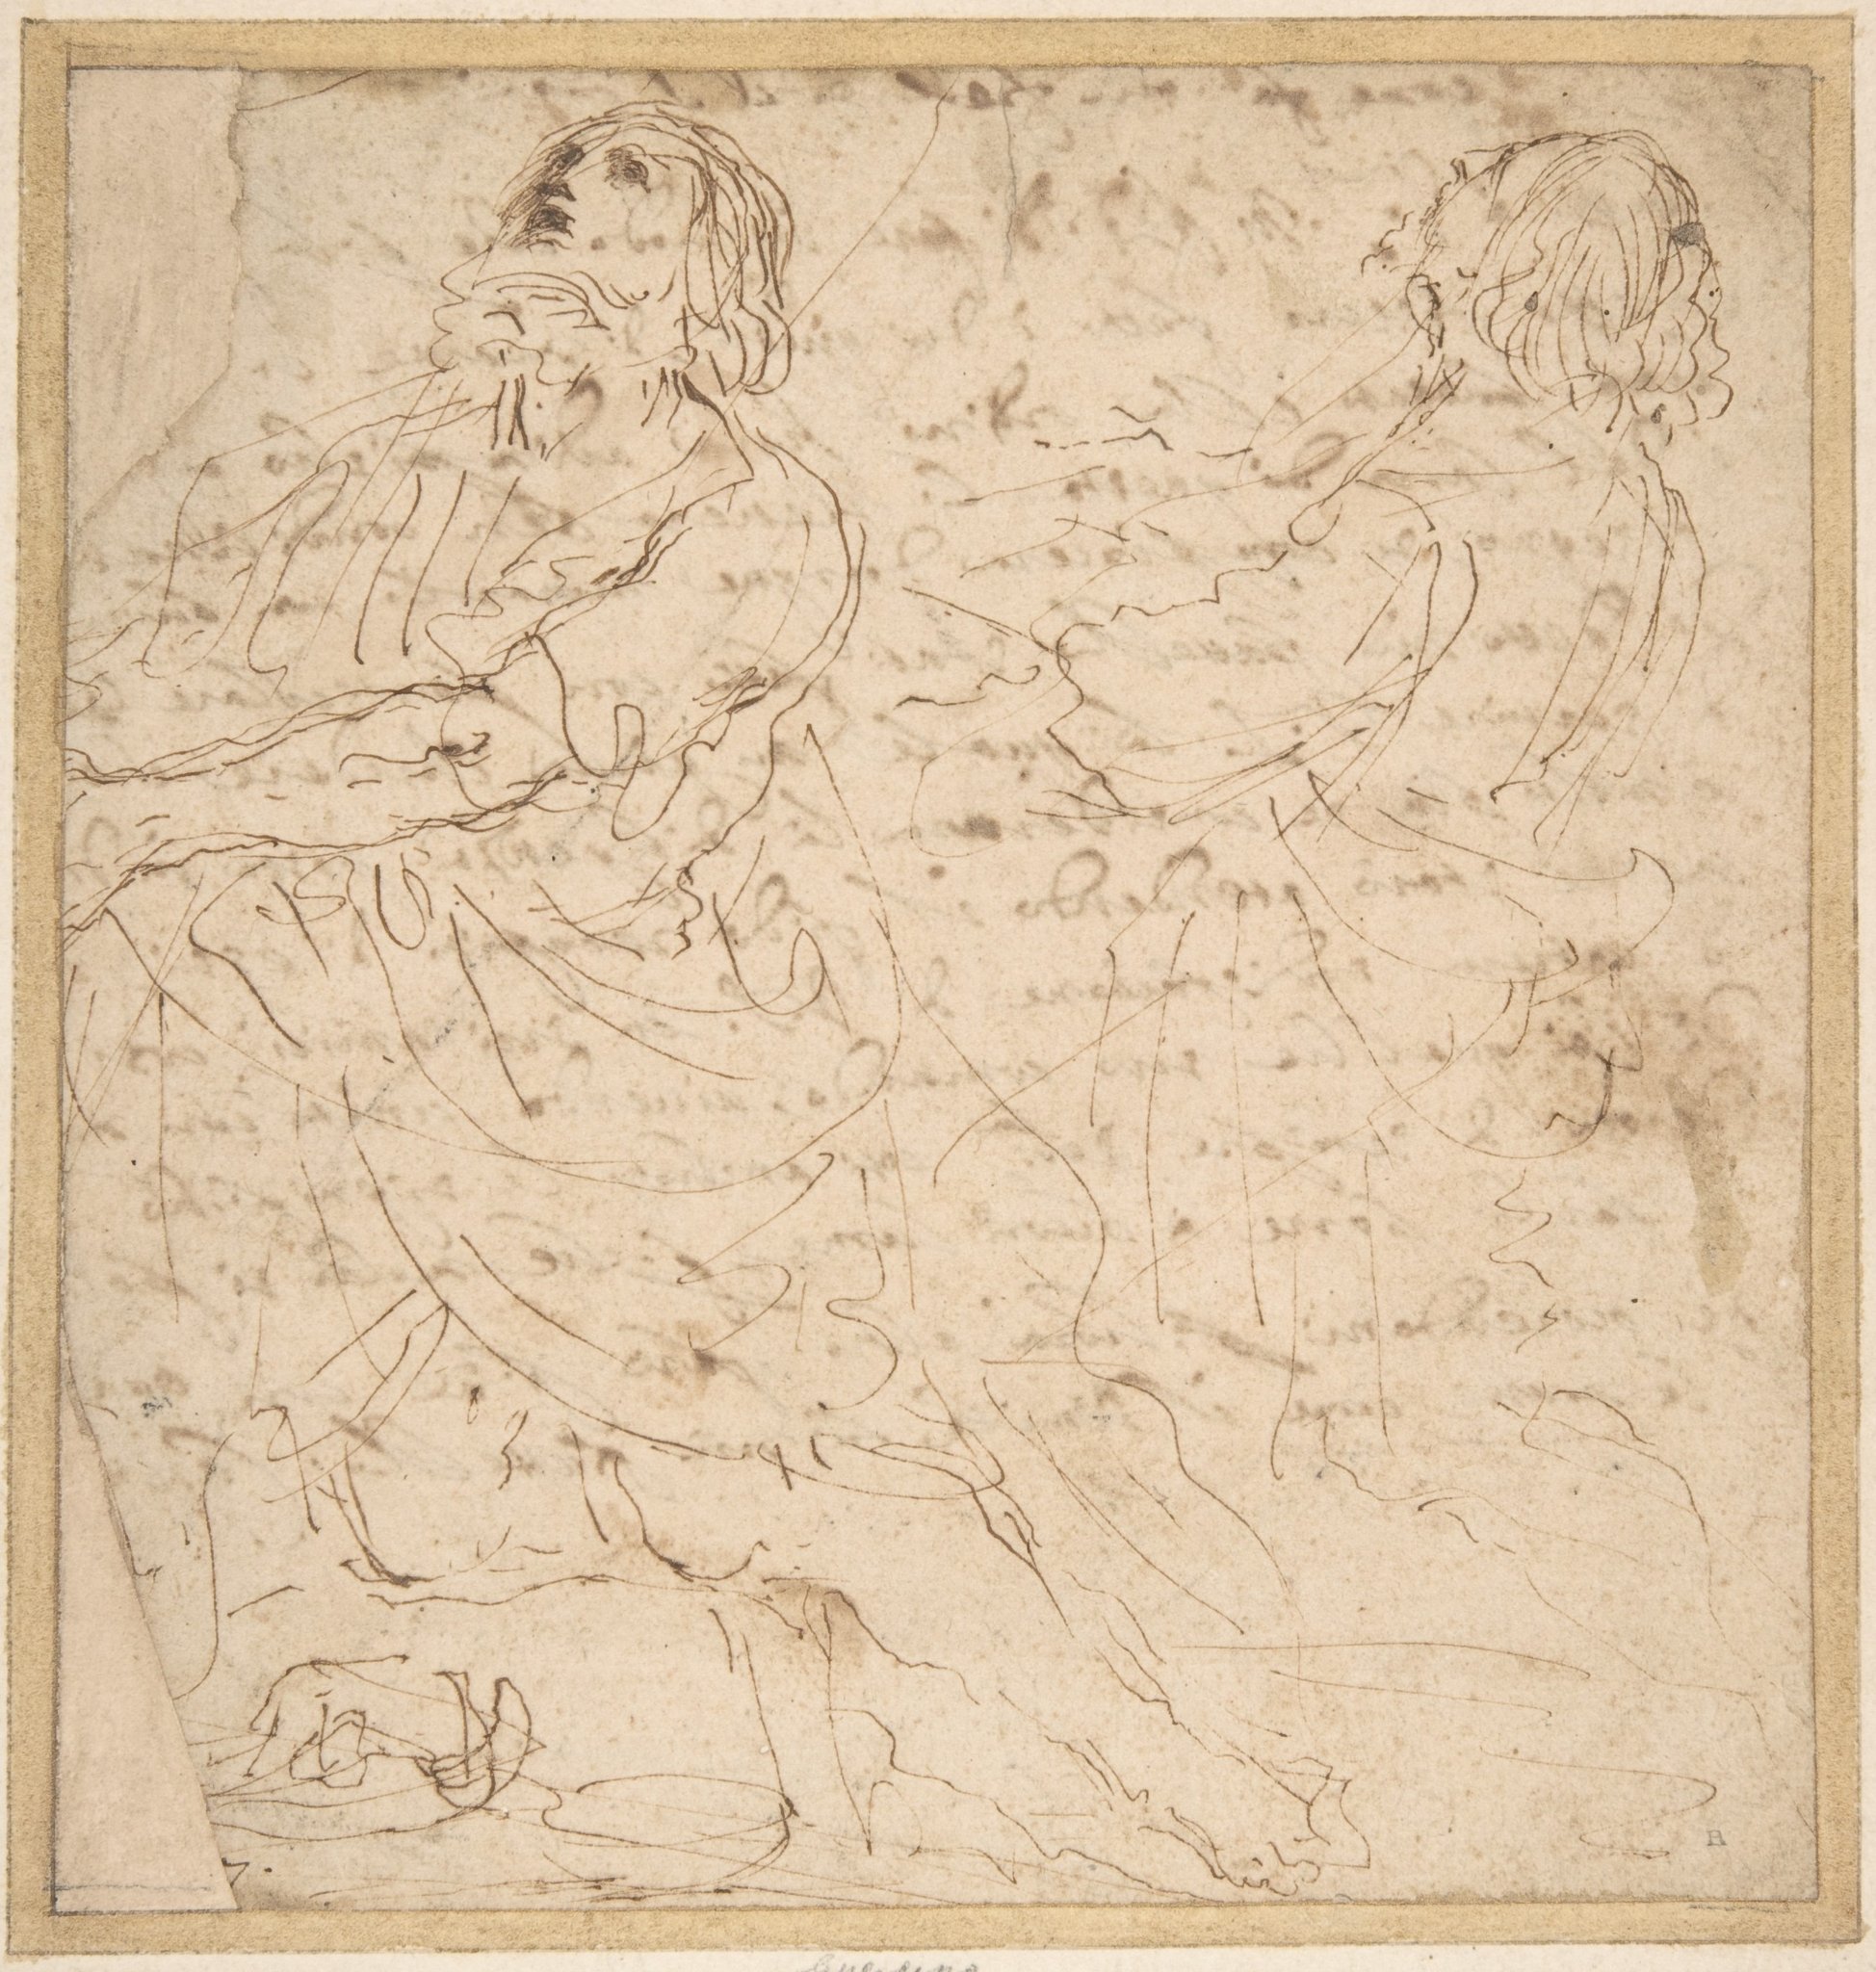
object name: drawing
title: Two Studies of a Kneeling Male Figure (recto); Handwritten letter (verso)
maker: guercino (giovanni francesco barbieri)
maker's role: artist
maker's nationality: italian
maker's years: 1591-1666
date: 1652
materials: ink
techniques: pen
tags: men